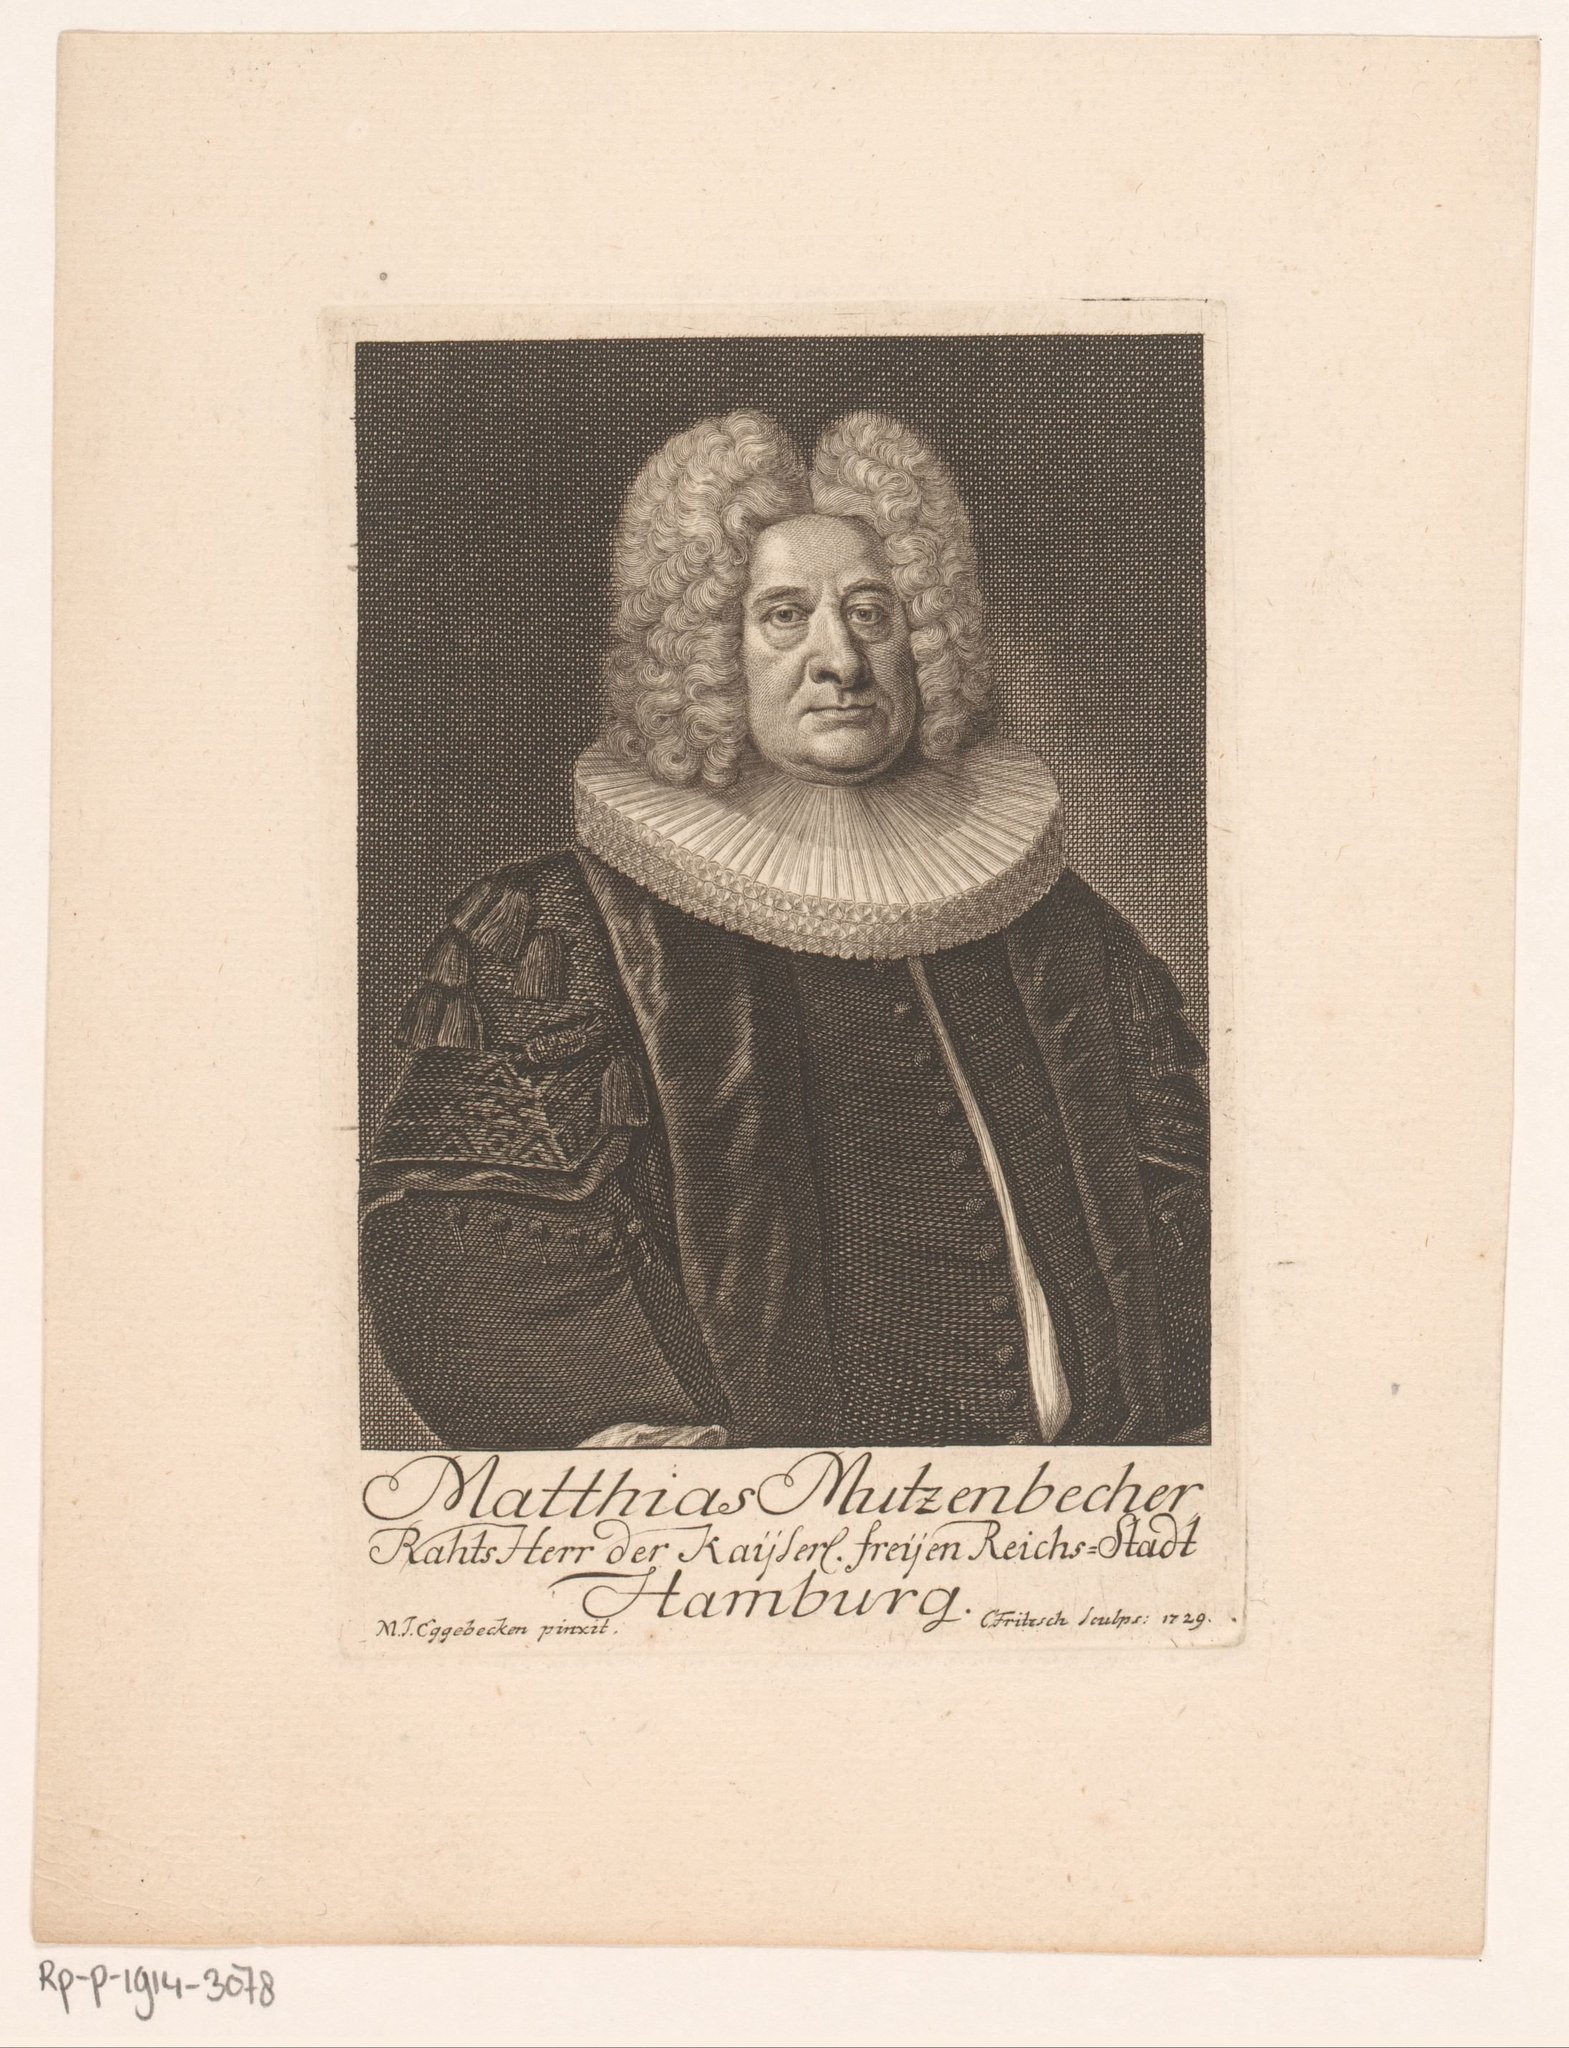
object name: print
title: Portret van Matthias Mutzenbecher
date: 1729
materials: paper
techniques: engraving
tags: historical persons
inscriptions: collector's mark: Lugt 2228